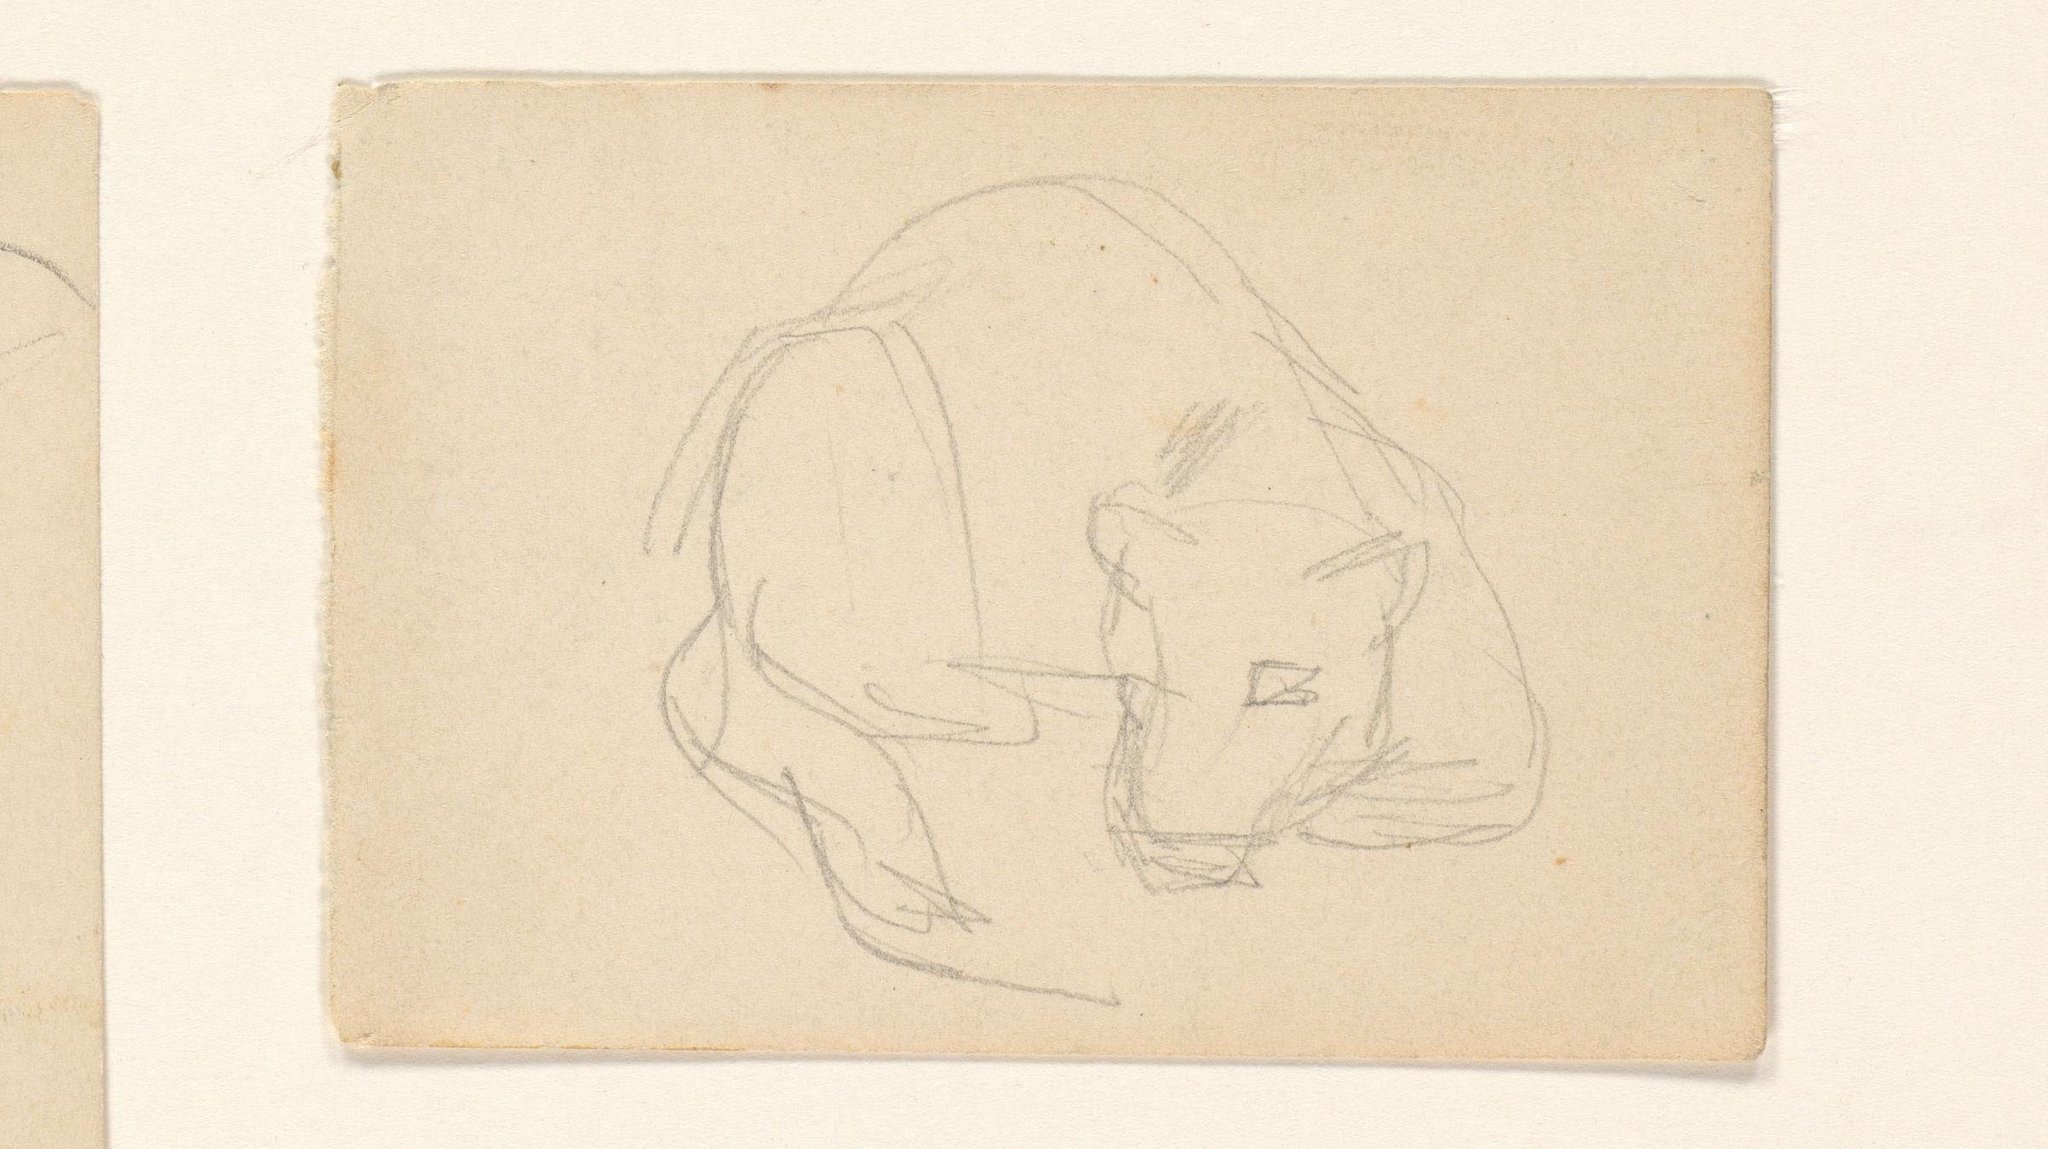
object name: drawing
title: Schetsblad met een katachtige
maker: august allebé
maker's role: draughtsman, print maker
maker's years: 1838-1927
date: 1848-1927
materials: paper, pencil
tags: beasts of prey, predatory animals